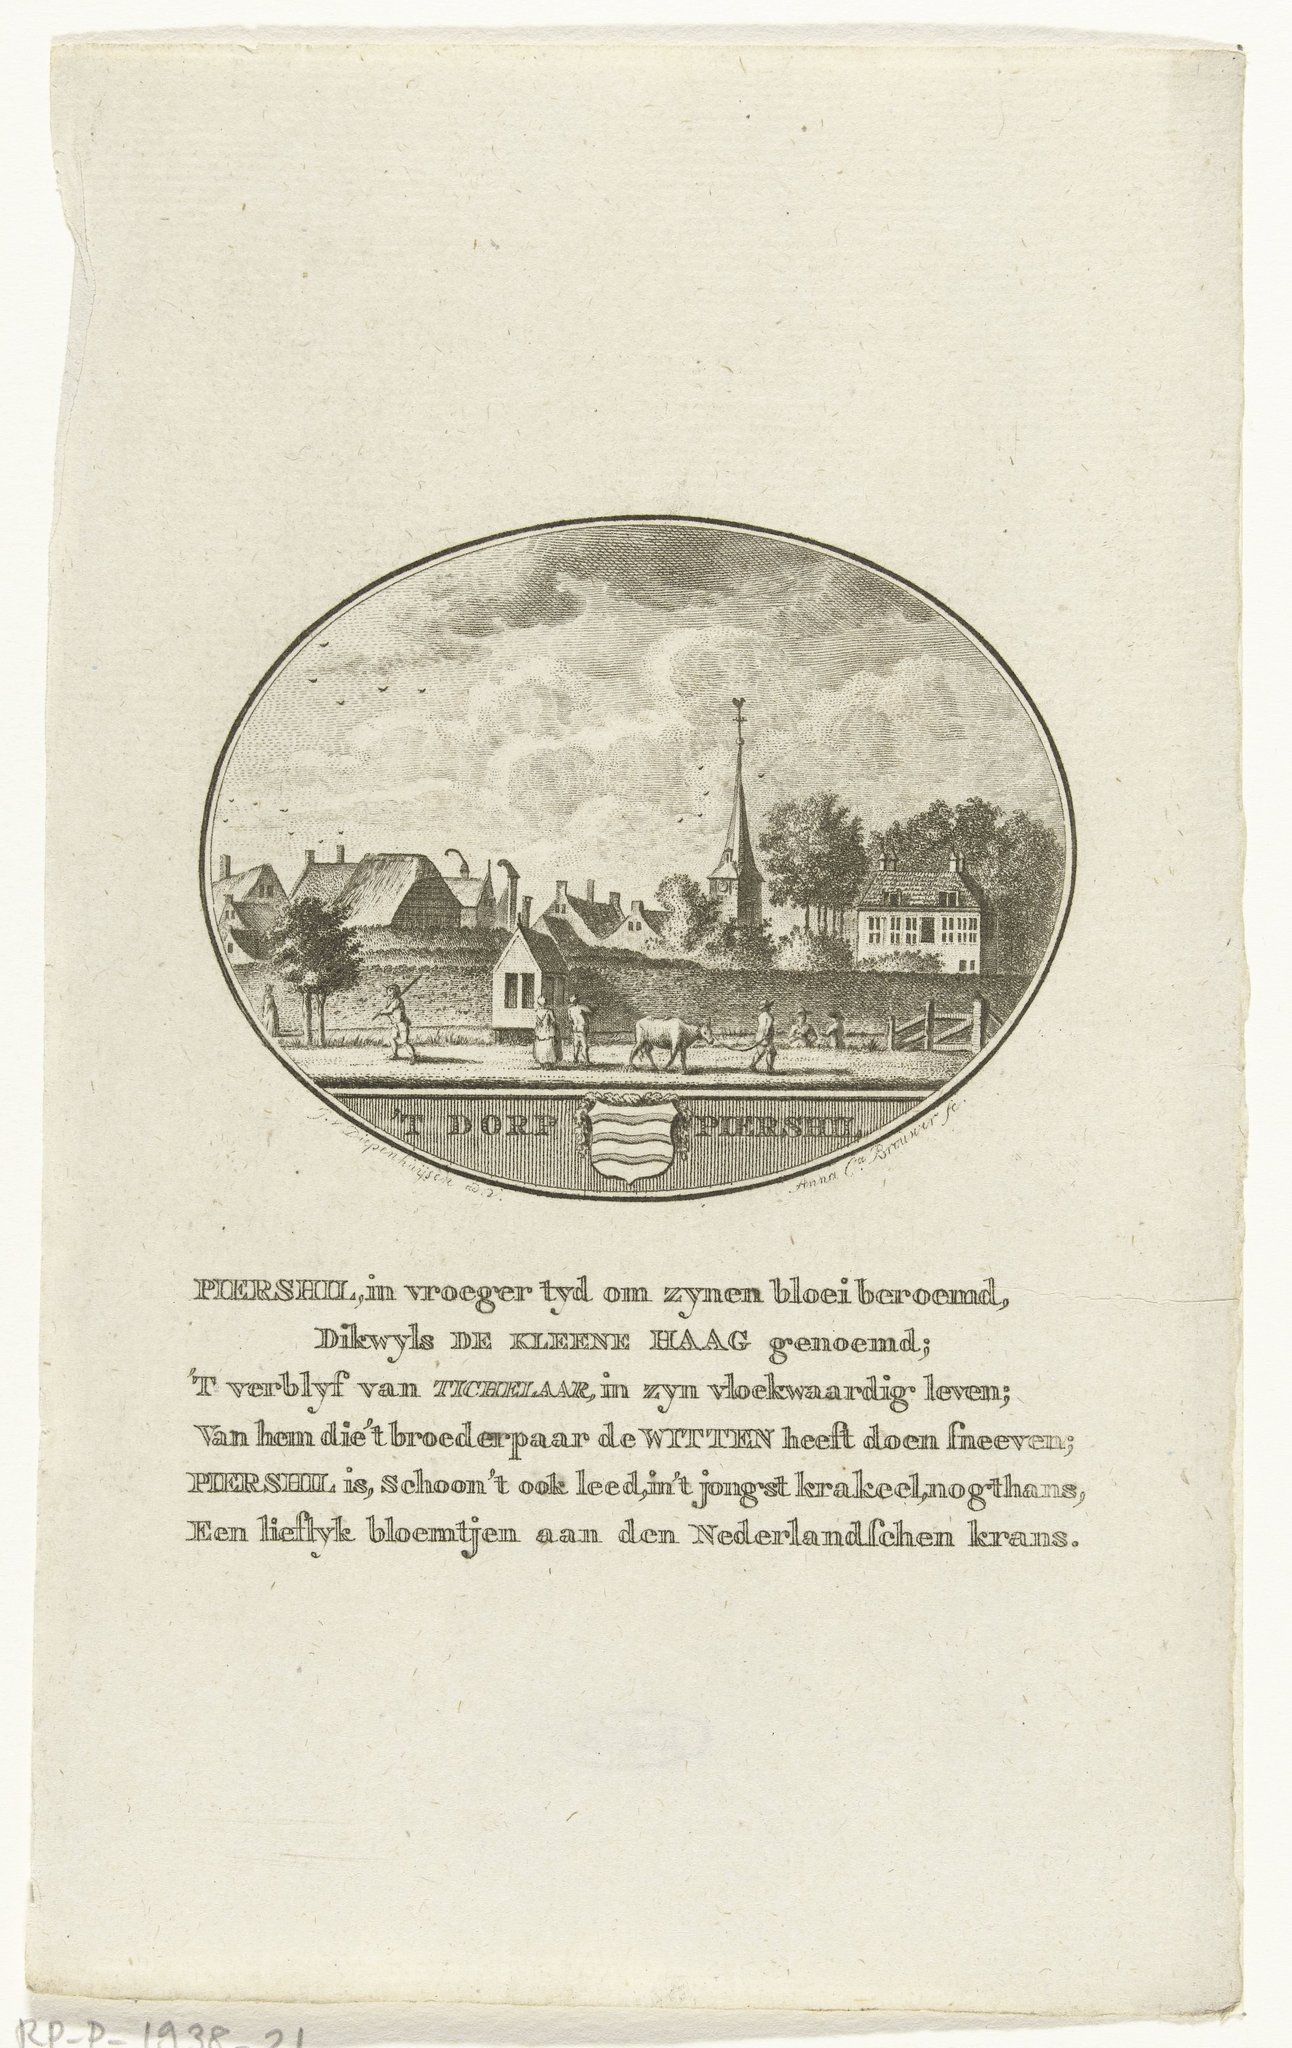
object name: book illustration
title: Gezicht op het dorp Piershil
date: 1791-1793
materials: paper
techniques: etching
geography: amsterdam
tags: city-view in general; 'veduta', piershil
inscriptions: collector's mark: Lugt 2228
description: afkomstig uit: L. van Ollefen, De Nederlandsche stad- en dorpbeschrijver. Deel 1. Amsterdam: H.A. Banse, 1793